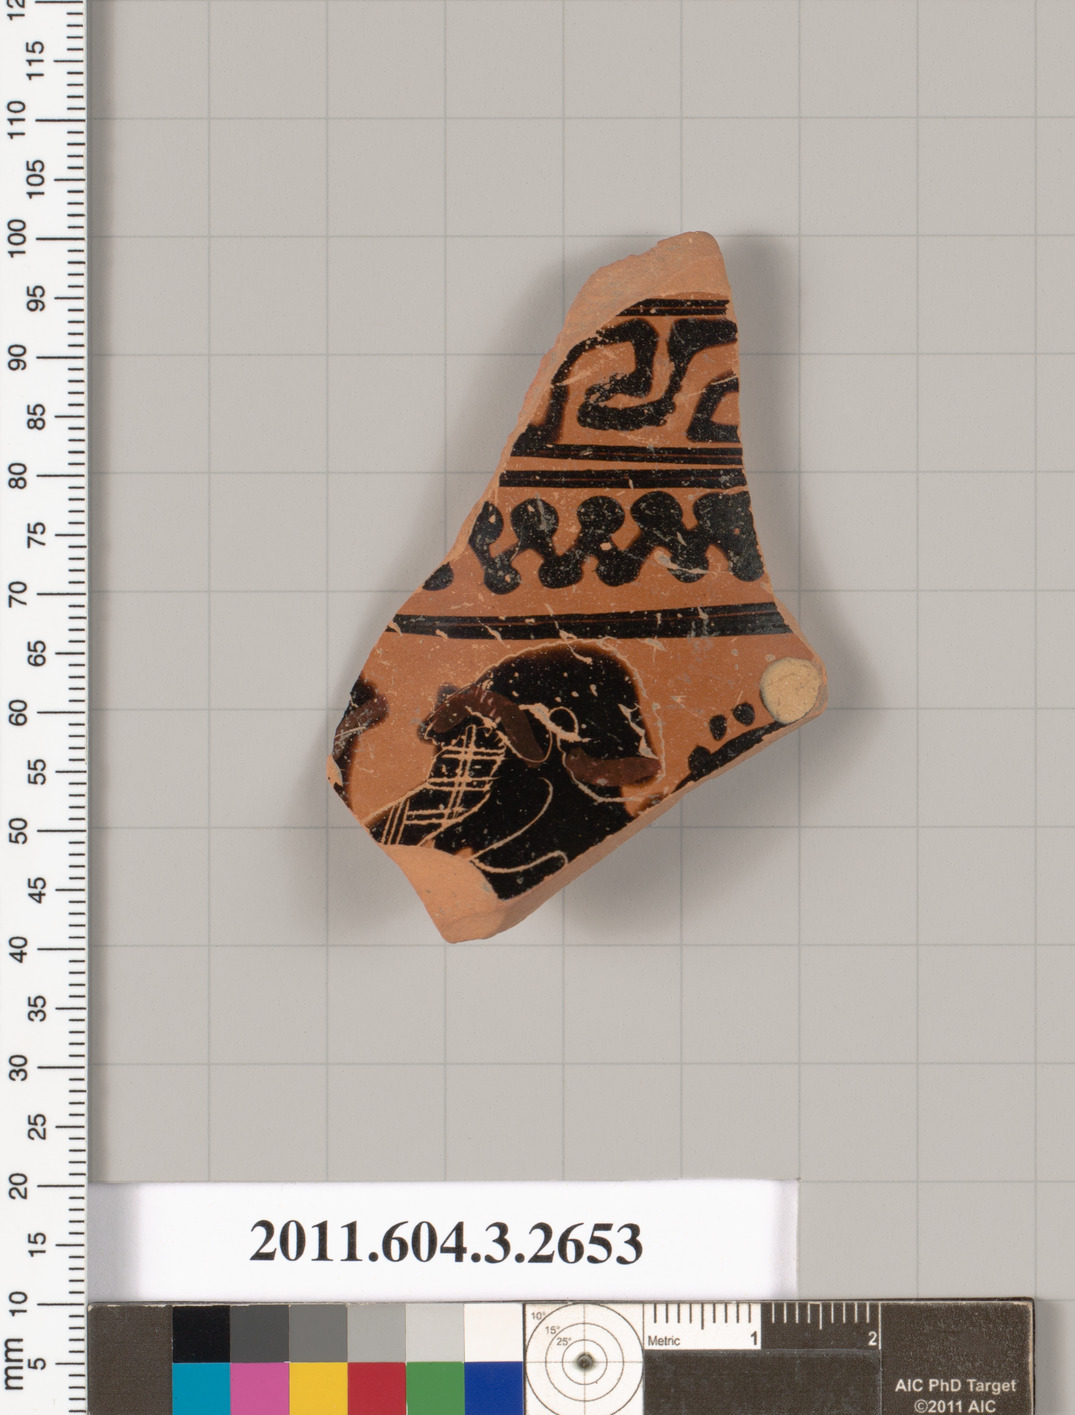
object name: olpe fragment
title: Terracotta fragment of an olpe (jug)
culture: greek, attic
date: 510-500 BCE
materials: terracotta